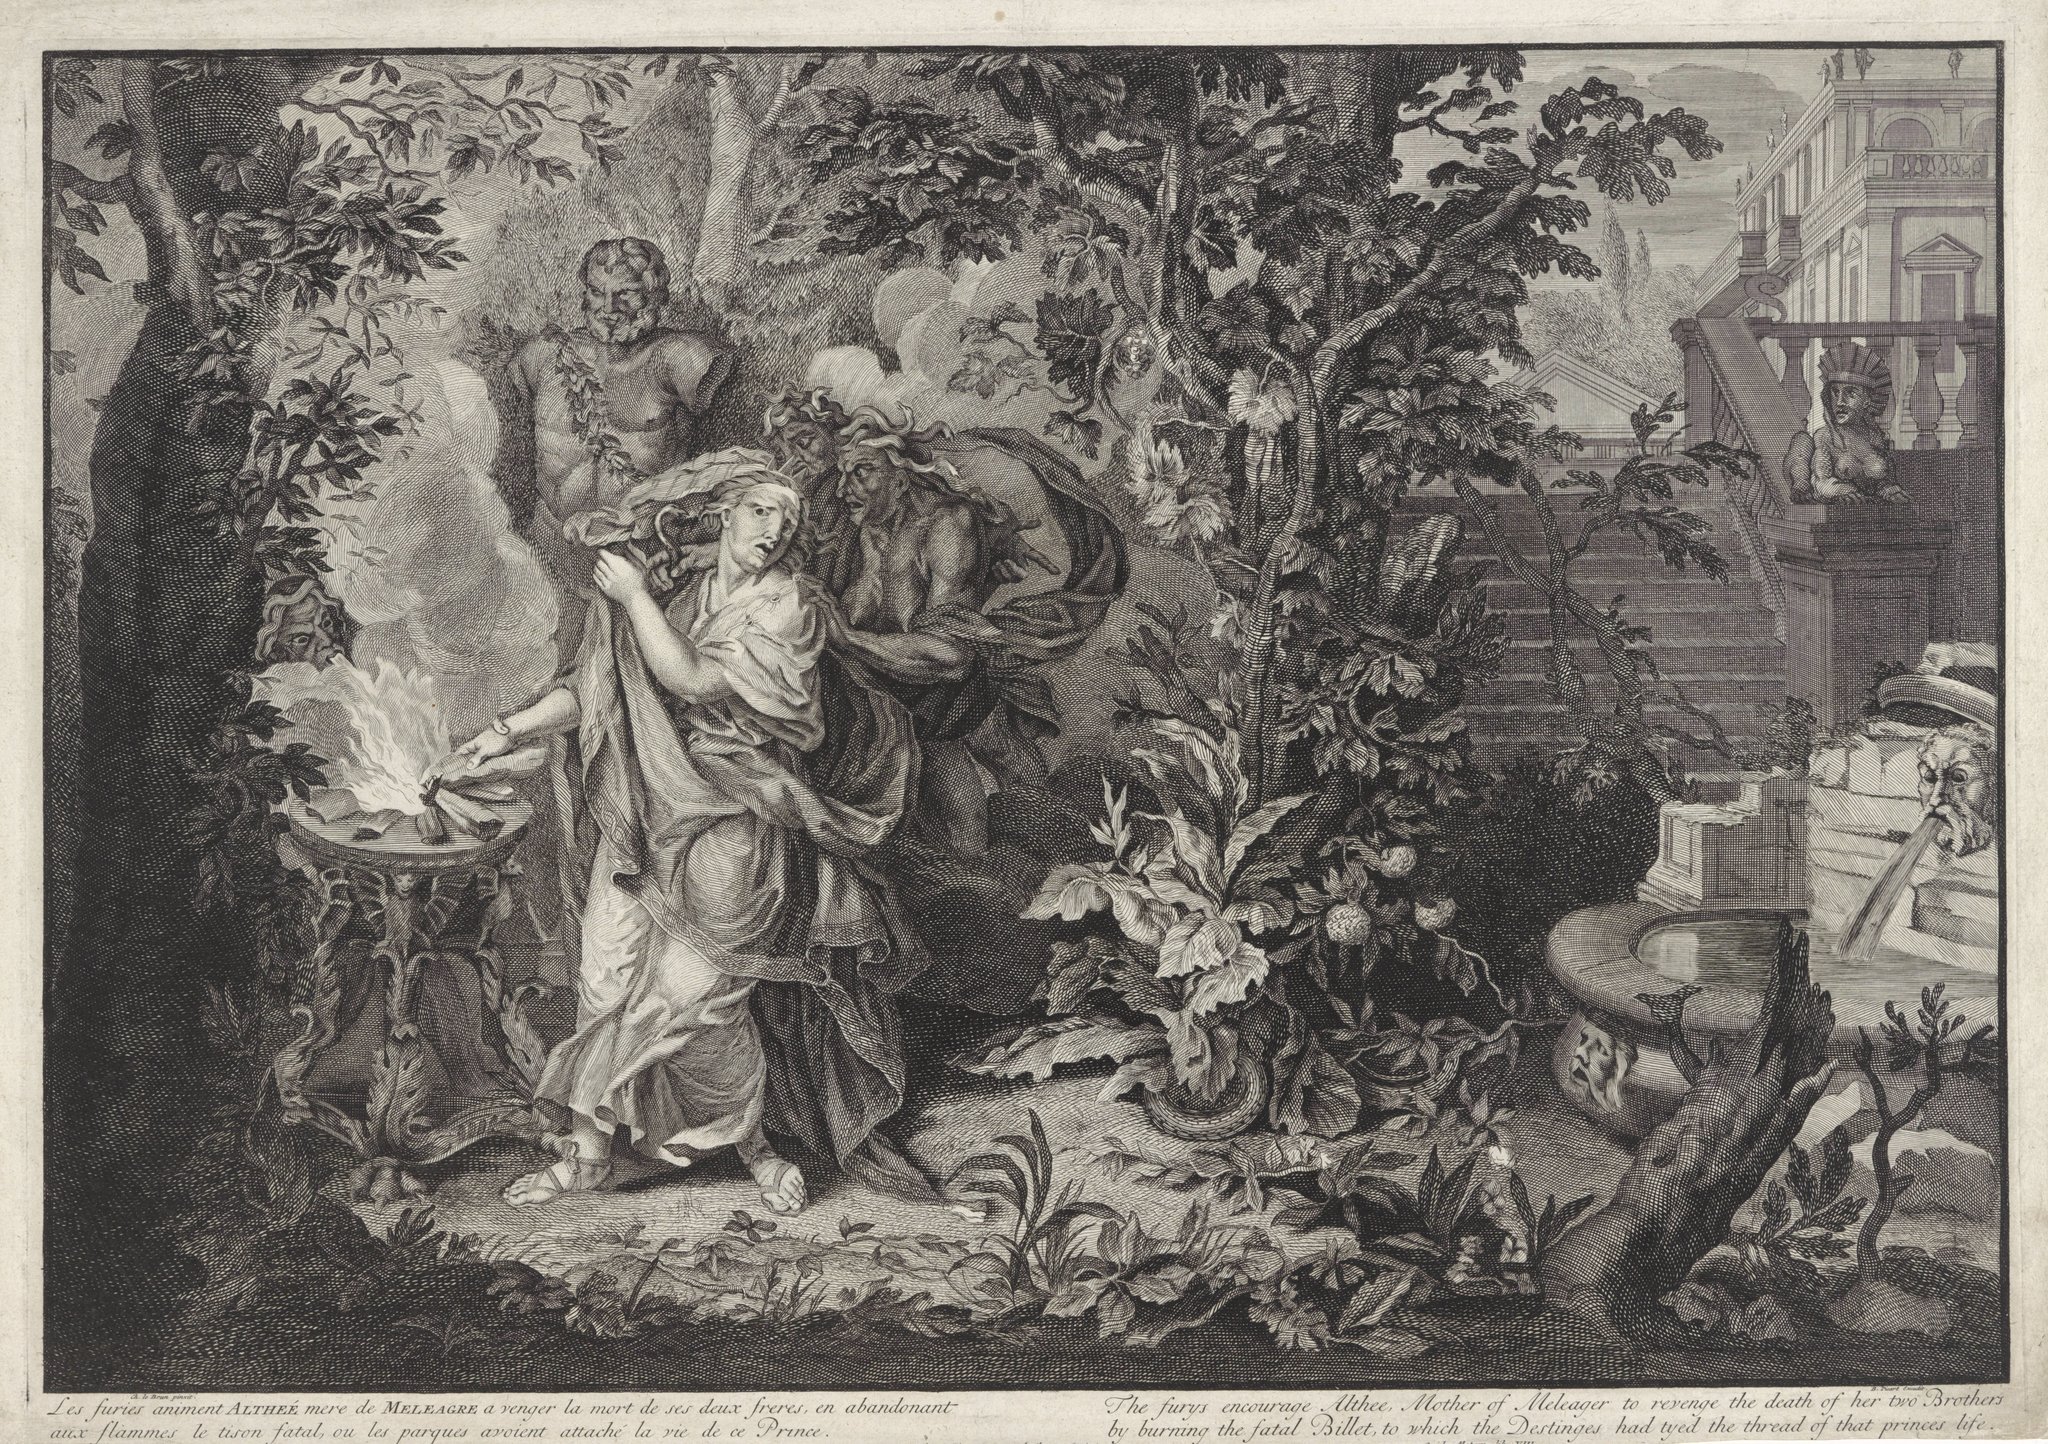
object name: print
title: Geschiedenis van Meleager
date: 1683-1710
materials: paper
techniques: engraving, etching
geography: paris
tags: althaea grieving at the death of her brothers, death of meleager: althaea throws the unburnt brand into the fire, thus causing meleager's death, furies, dirae (erinyes), eumenides; 'furie' (ripa)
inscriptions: collector's mark: Lugt 2233, collector's mark: Lugt 2228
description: Althaea, de moeder van Meleager, gooit onder invloed van twee wraakgodinnen, het houtblok van Meleager in het vuur. Meleager had bij een twist om het Caledonische zwijn zijn beide ooms, de broers van zijn moeder, gedood. Bij Meleagers geboorte hadden de drie schikgodinnen bepaald dat hij niet zou sterven vóór een bepaald houtblok zou zijn verteerd. Uit wraak gooit Althaea het blok terug in het vuur. Onder de voorstelling een verklarende tekst in het Frans en het Engels.